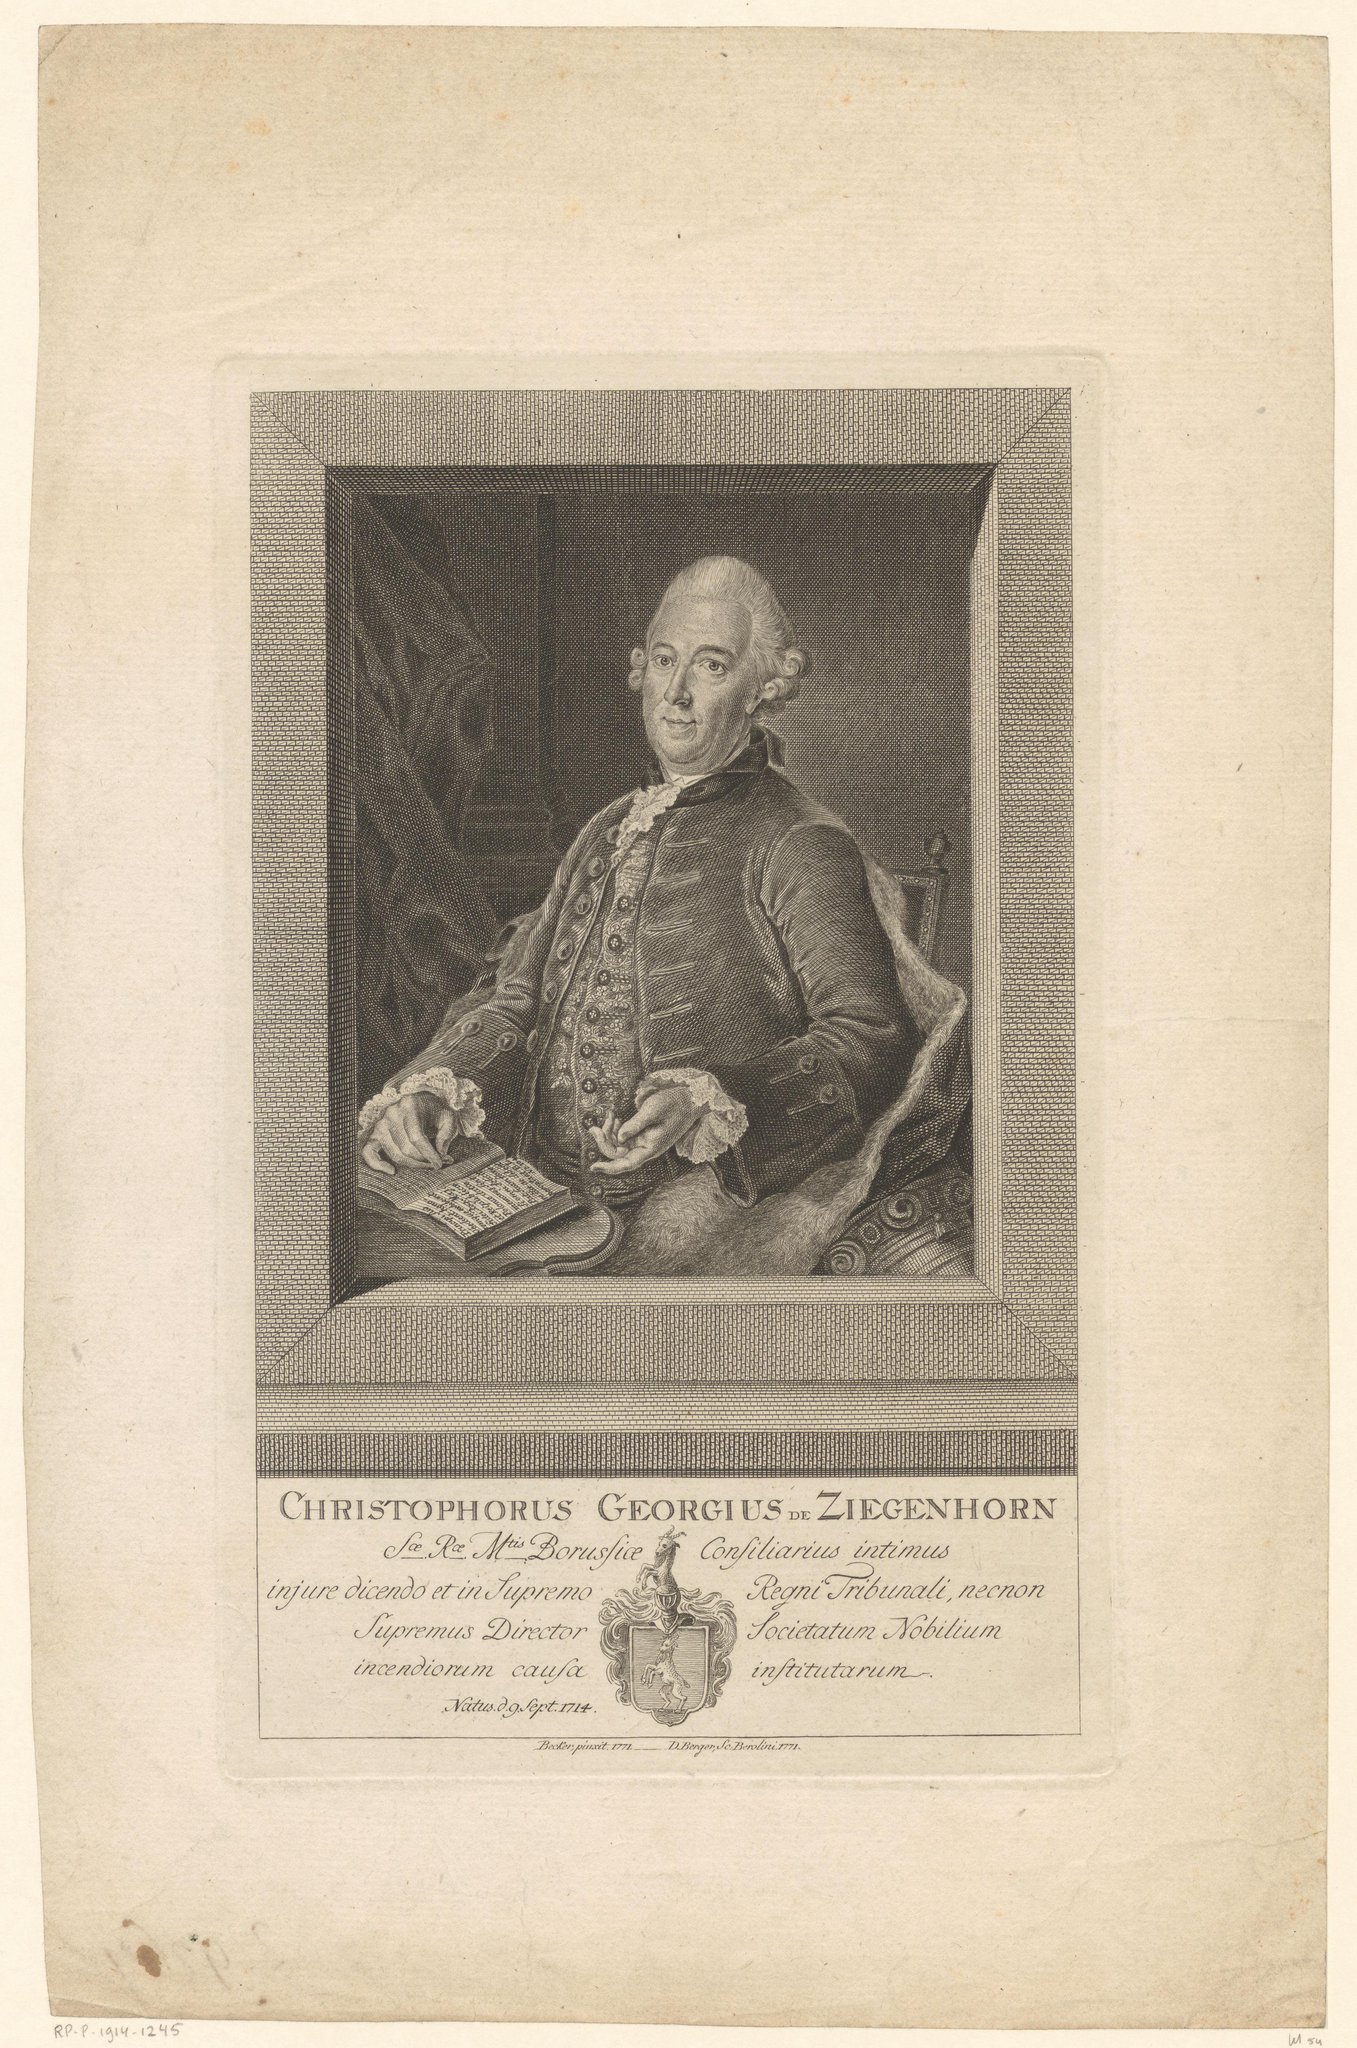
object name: print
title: Portret van Christoph Georg von Ziegenhorn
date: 1771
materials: paper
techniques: engraving, etching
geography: berlin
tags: historical persons, book, armorial bearing, heraldry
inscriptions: collector's mark: Lugt 358, collector's mark: Lugt 2228